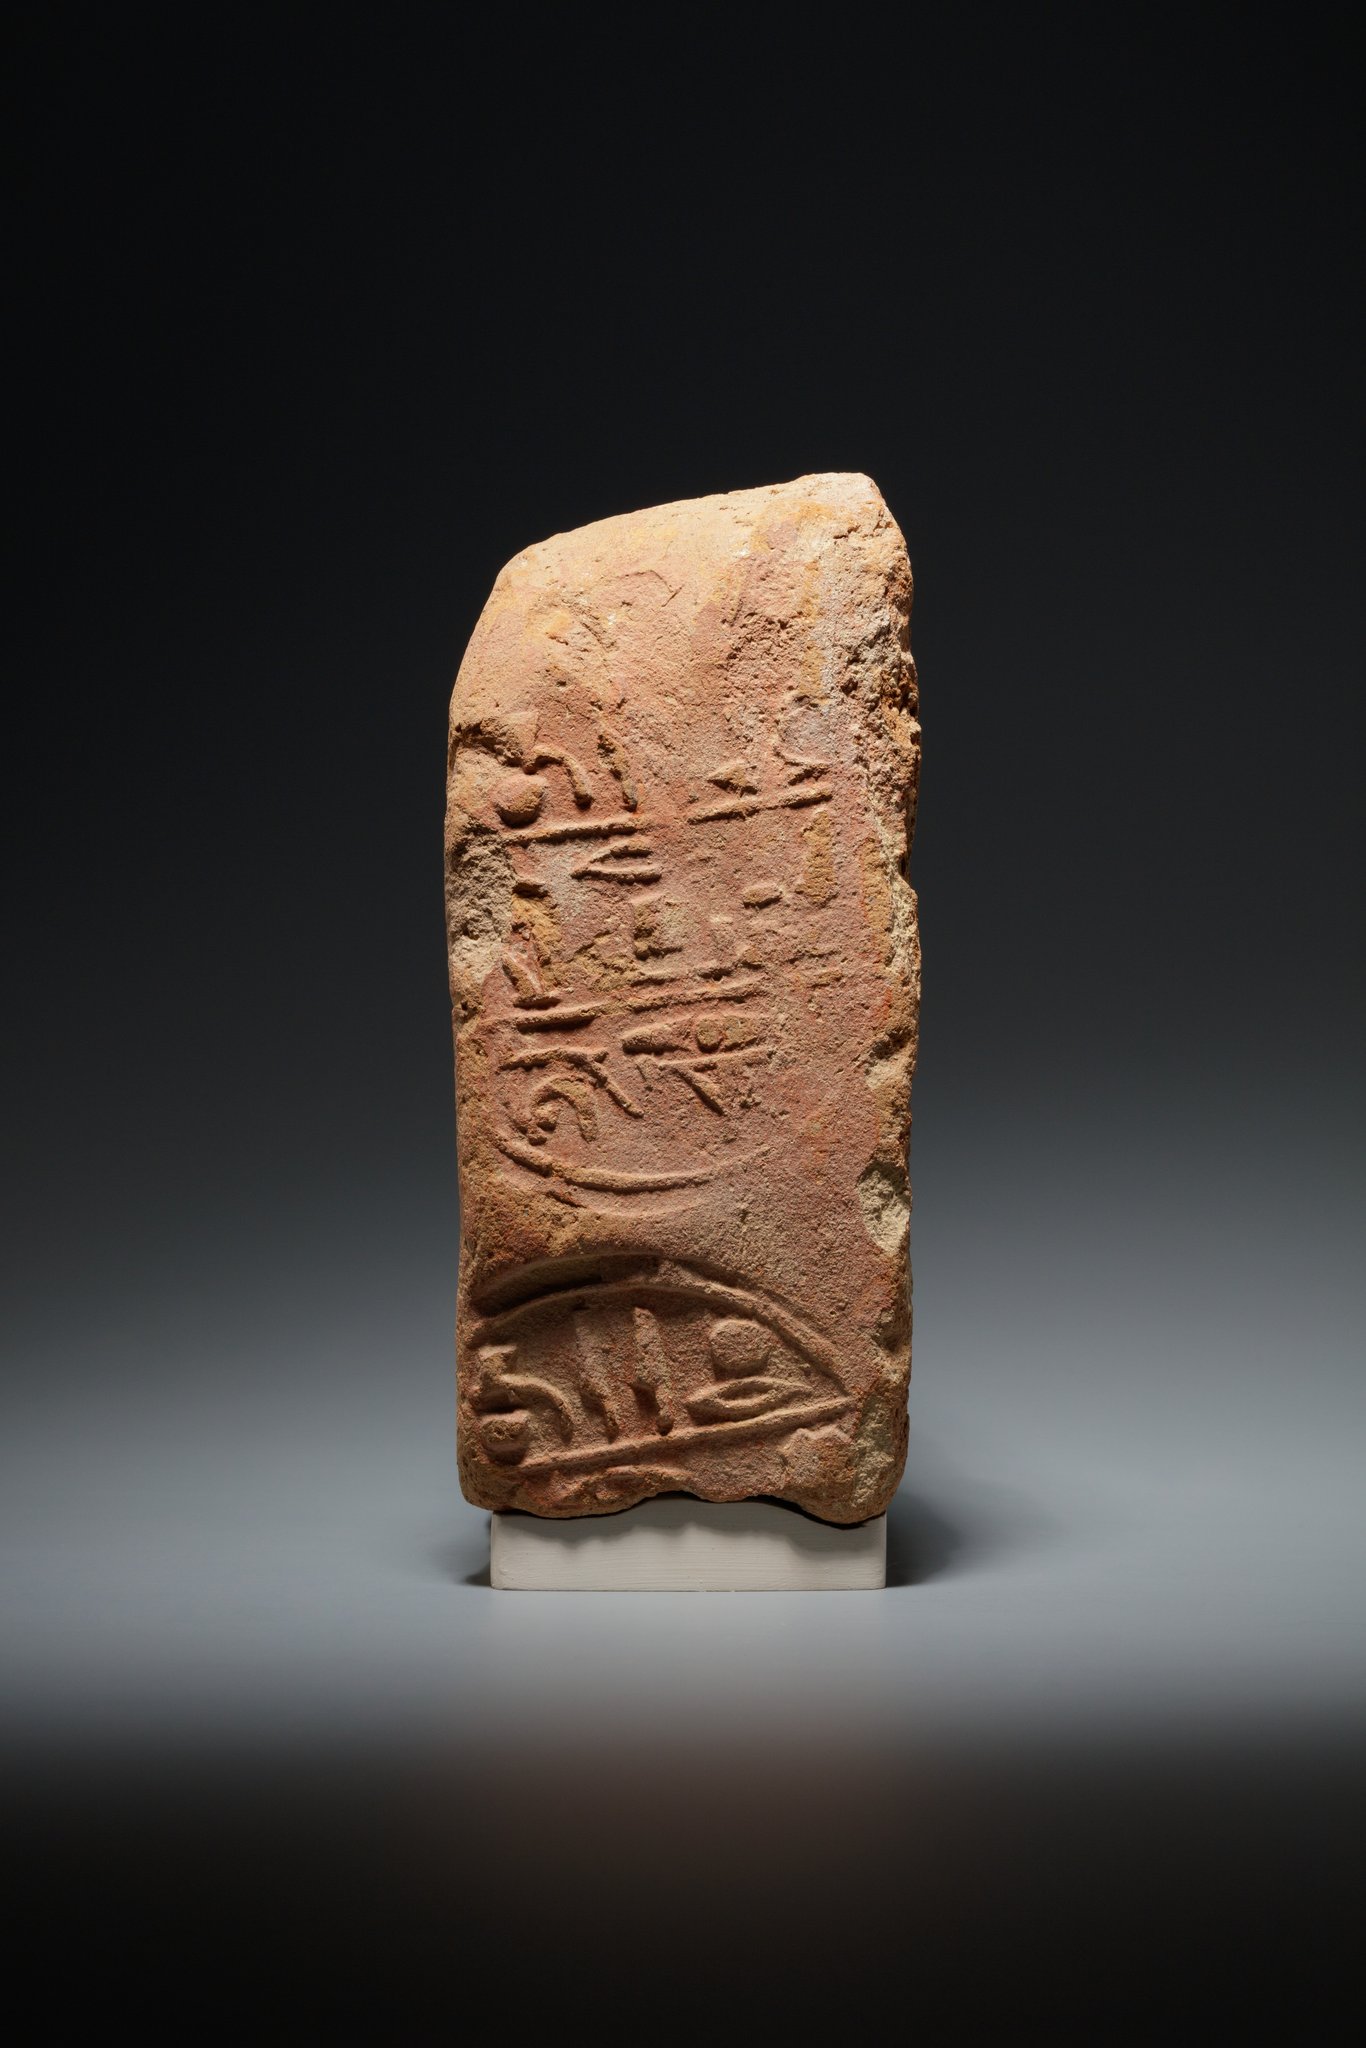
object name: cone, brick, davy 499, min, overseer, seal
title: Brick Stamped with the Name and Titles of Min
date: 1550-1295 BCE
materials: pottery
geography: egypt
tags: hieroglyphs